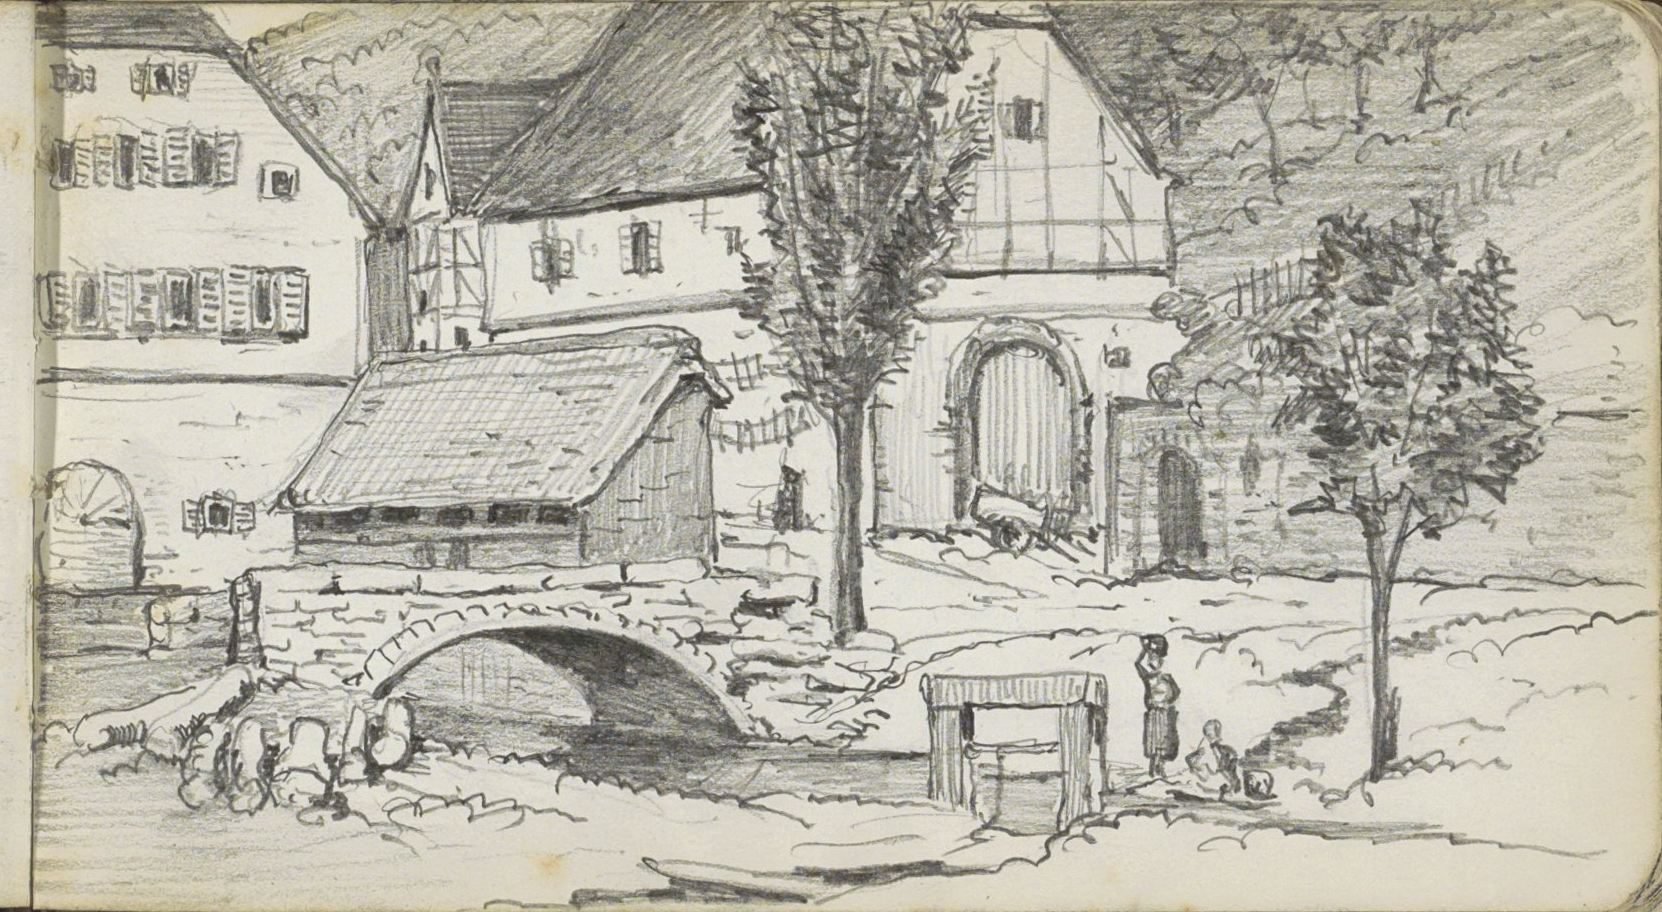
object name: sketchbook leaf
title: Huizen en figuren langs de Neckar te Hirschhorn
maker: geo poggenbeek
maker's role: draughtsman, painter, print maker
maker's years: 1853-1903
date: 1807-1876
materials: paper, pencil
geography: hirschhorn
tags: river, river bank (+ landscape with figures, staffage)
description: Blad 31 recto uit een schetsboek met 69 bladen.